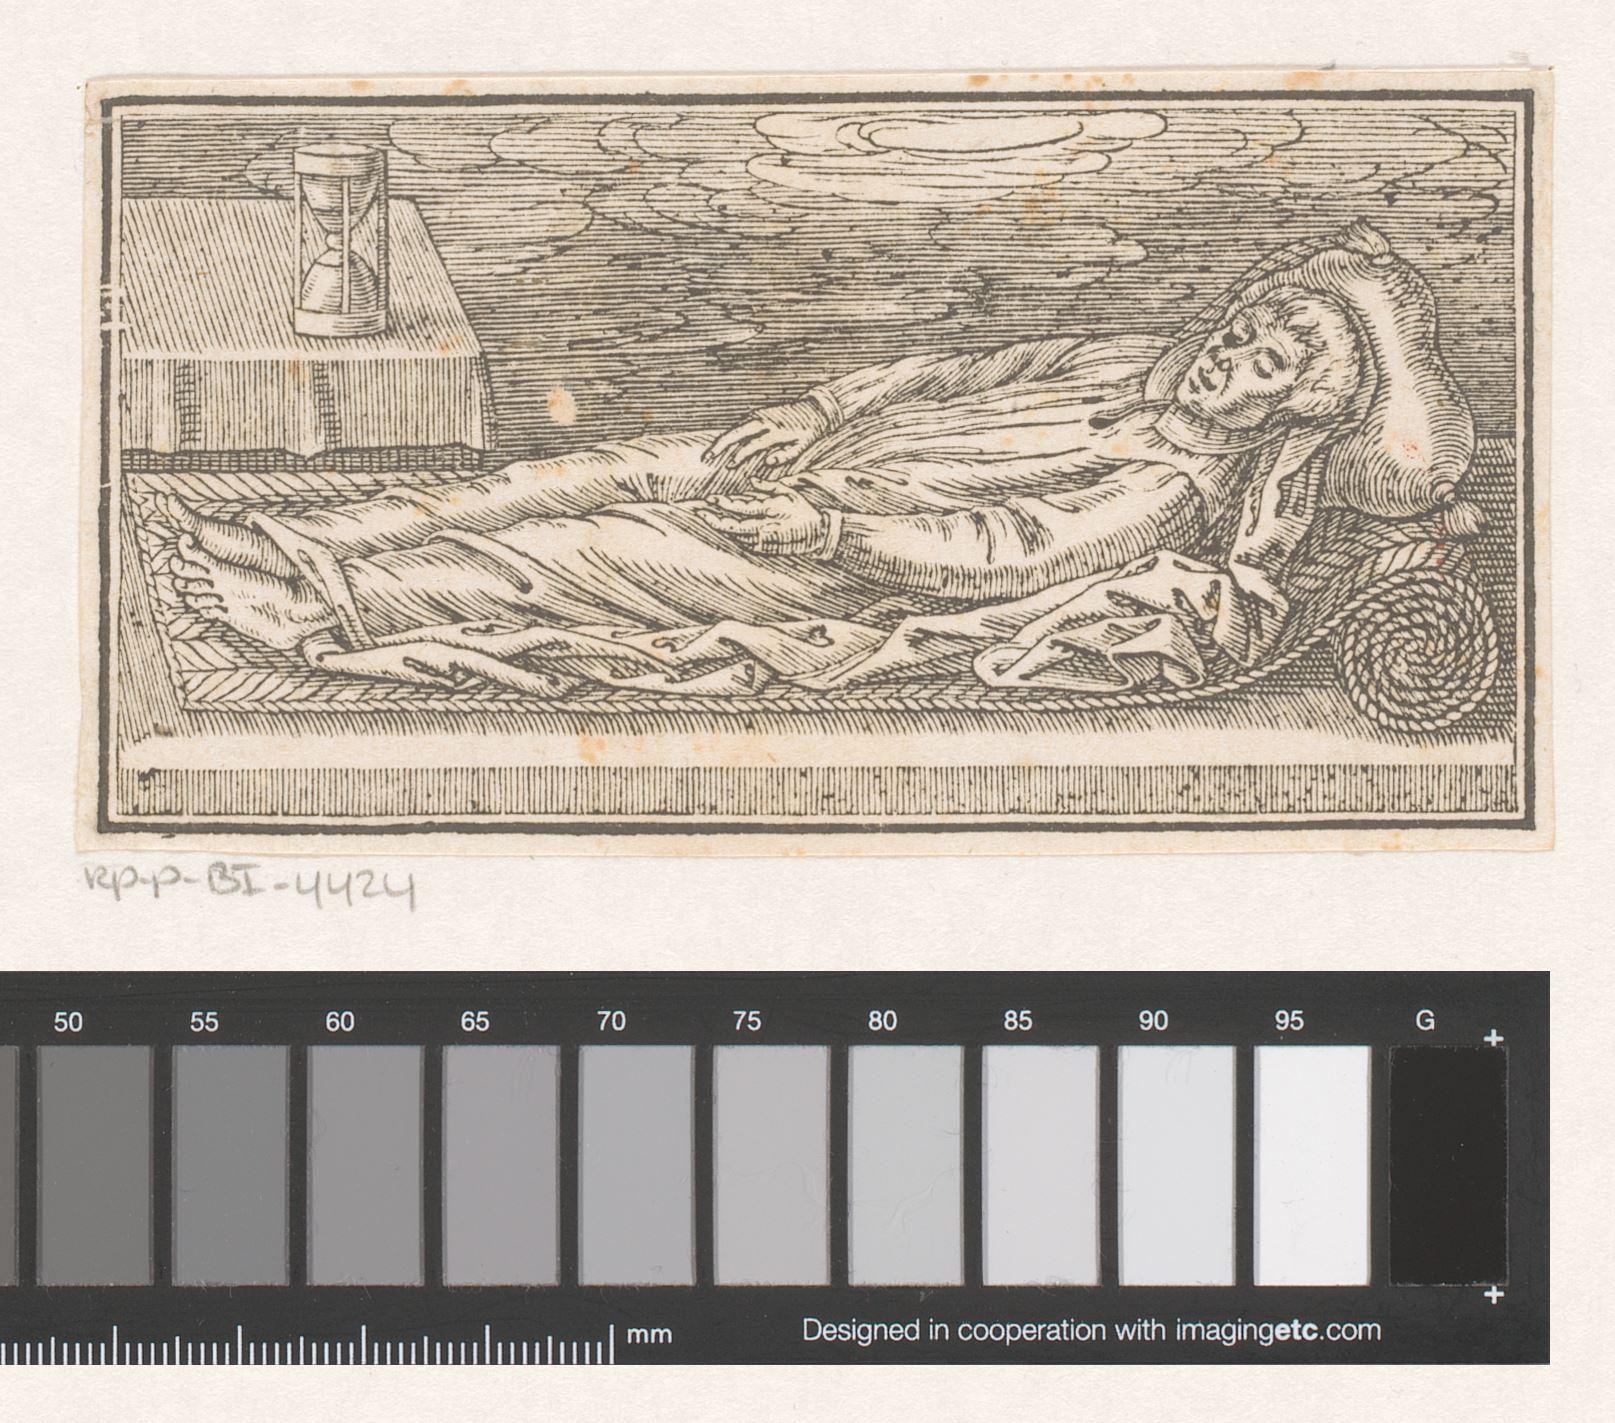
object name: print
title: Opgebaard lichaam naast een zandloper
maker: Anonymous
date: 1600-1699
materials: paper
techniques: woodcut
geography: netherlands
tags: hourglass, the corpse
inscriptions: collector's mark: Lugt 240